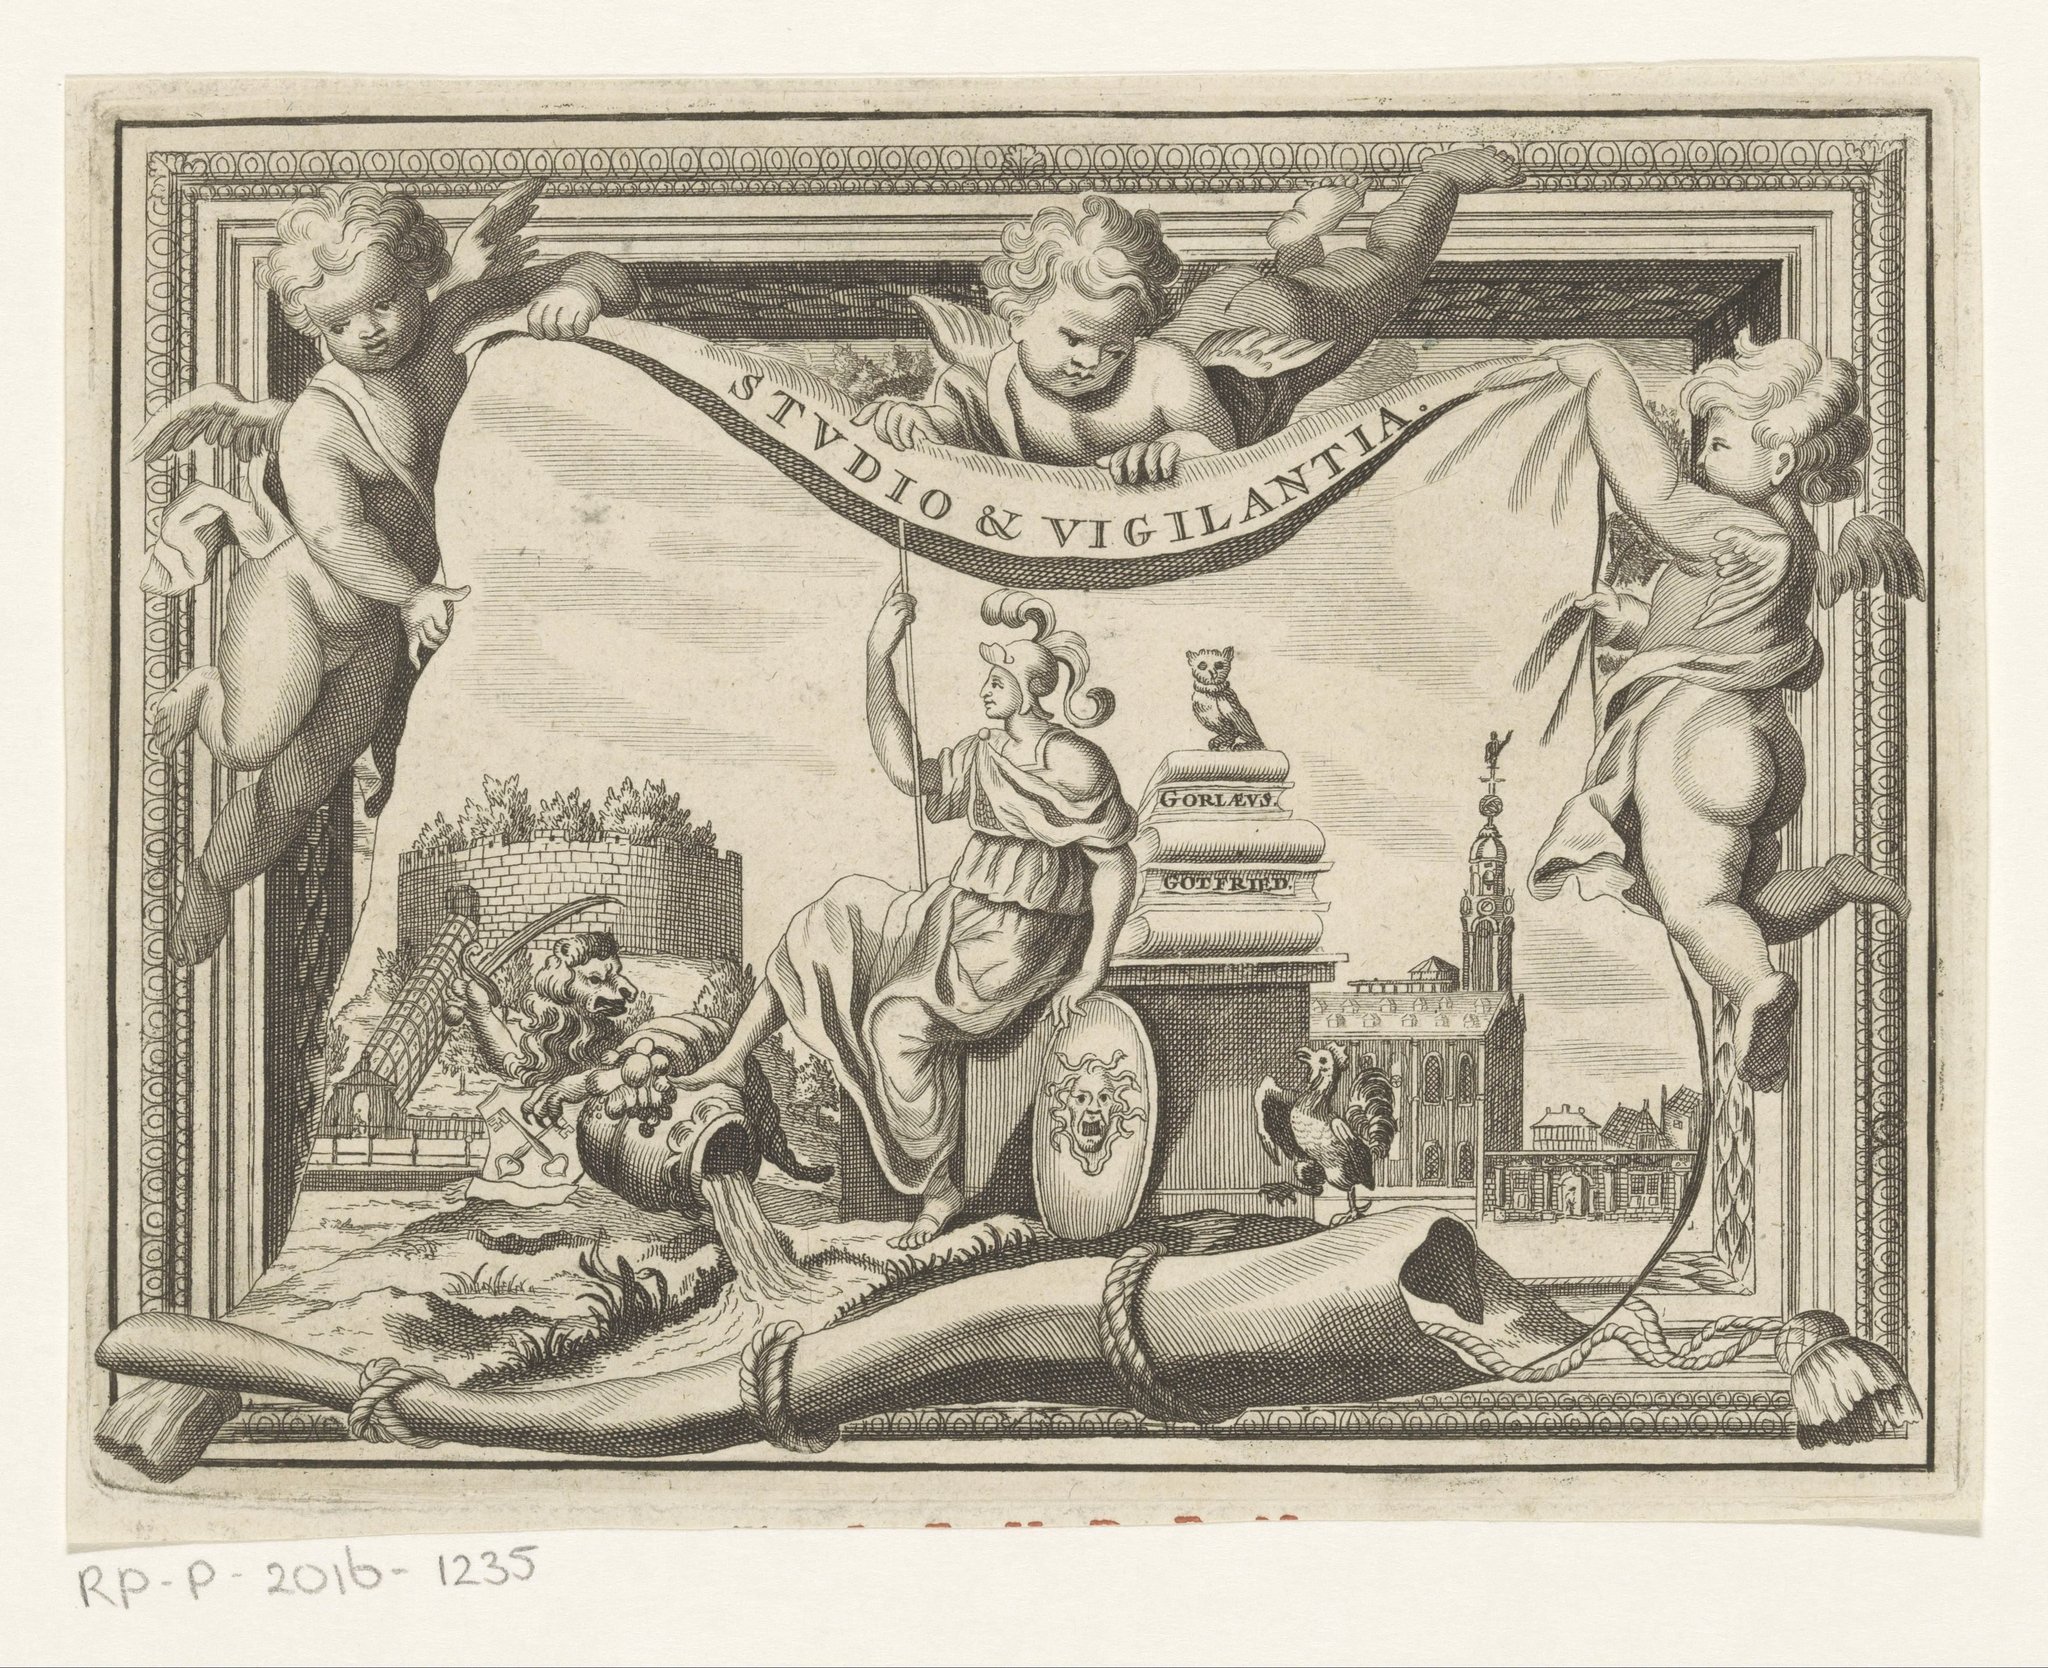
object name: print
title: Vignet met Minerva en putti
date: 1698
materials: paper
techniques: engraving, etching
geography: leiden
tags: (story of) minerva (pallas, athena), cupids: 'amores', 'amoretti', 'putti', city represented symbolically, leiden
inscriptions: collector's mark: Lugt 2228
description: Drie putti houden een rol met afbeelding vast van Minerva met schild en lans zittend op een voetstuk waarop boeken van David van Goorle (Gorlaeus) en Johann Ludwig Gottfried. Met haar voet rust zij op een stromende kruik. Daarnaast zit een leeuw met zwaard en wapen van Leiden. In de achtergrond de burcht en Universiteit van Leiden.